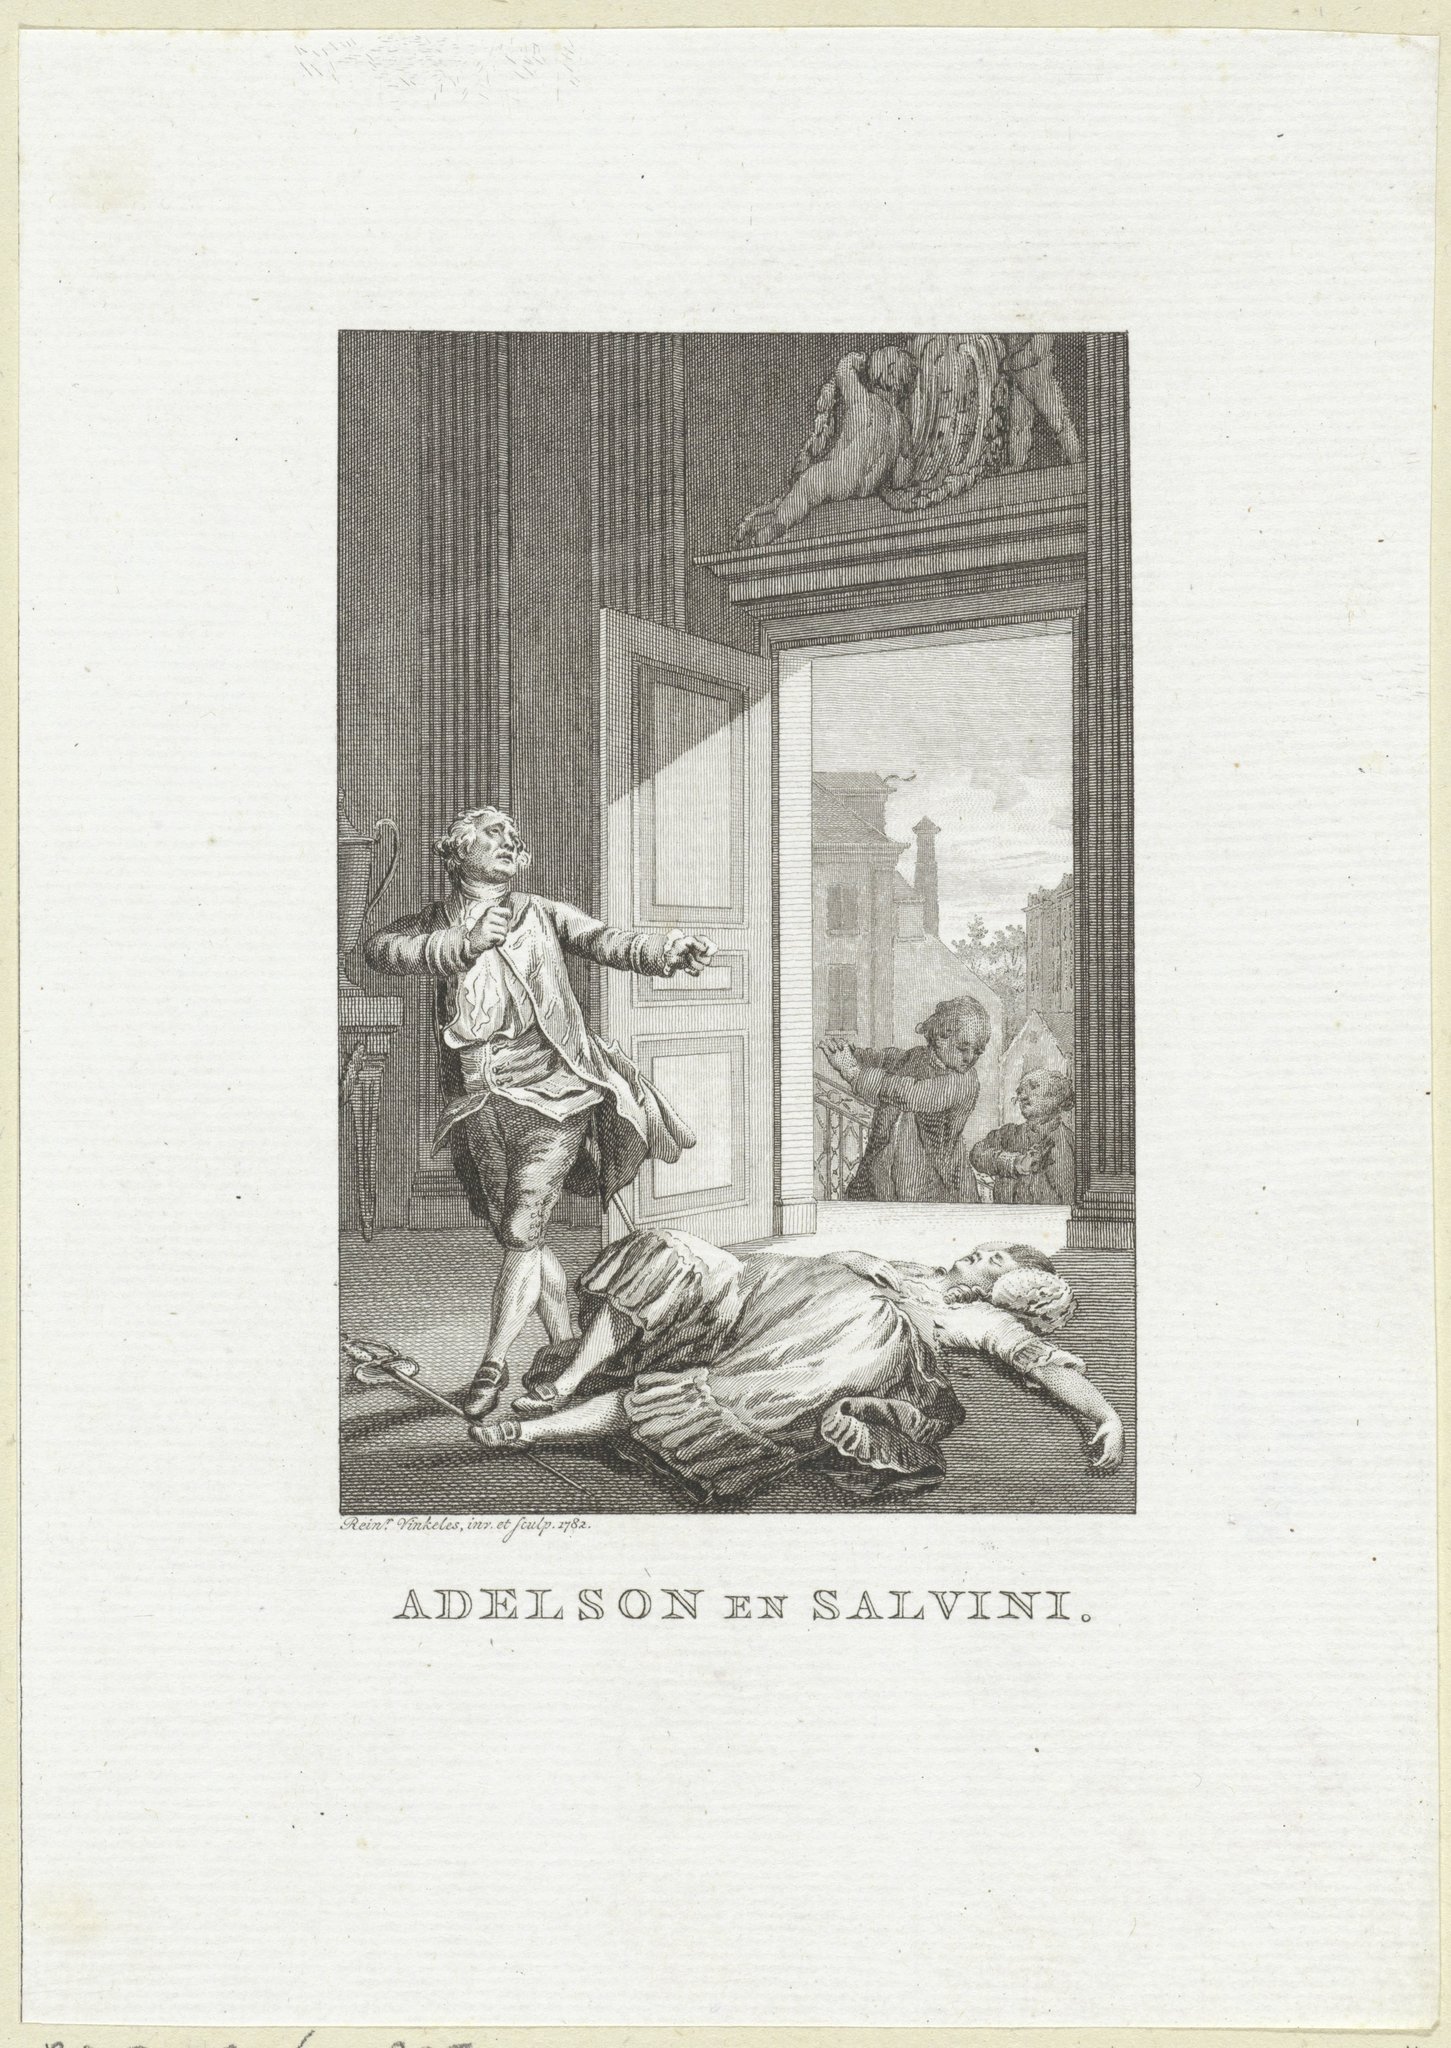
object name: print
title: Man balt zijn vuisten bij het aanzicht van een dode vrouw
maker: reinier vinkeles (i)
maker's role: draughtsman, print maker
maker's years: 1741-1816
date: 1782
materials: paper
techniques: engraving, etching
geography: amsterdam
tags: violent death, being killed; being mishandled and maltreated; seeking death - ee - death not certain; wounded person (+ death by murder), hand made into a fist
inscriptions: collector's mark: Lugt 240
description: Proefdruk van een prent die ook gebruikt is als illustratie bij het verhaal 'Adelson en Salvini' voor: Baculard d'Arnaud, F.T.M. de. Zedelijke verhaalen, deel 7. Amsterdam: A. Mens Jansz., 1782.